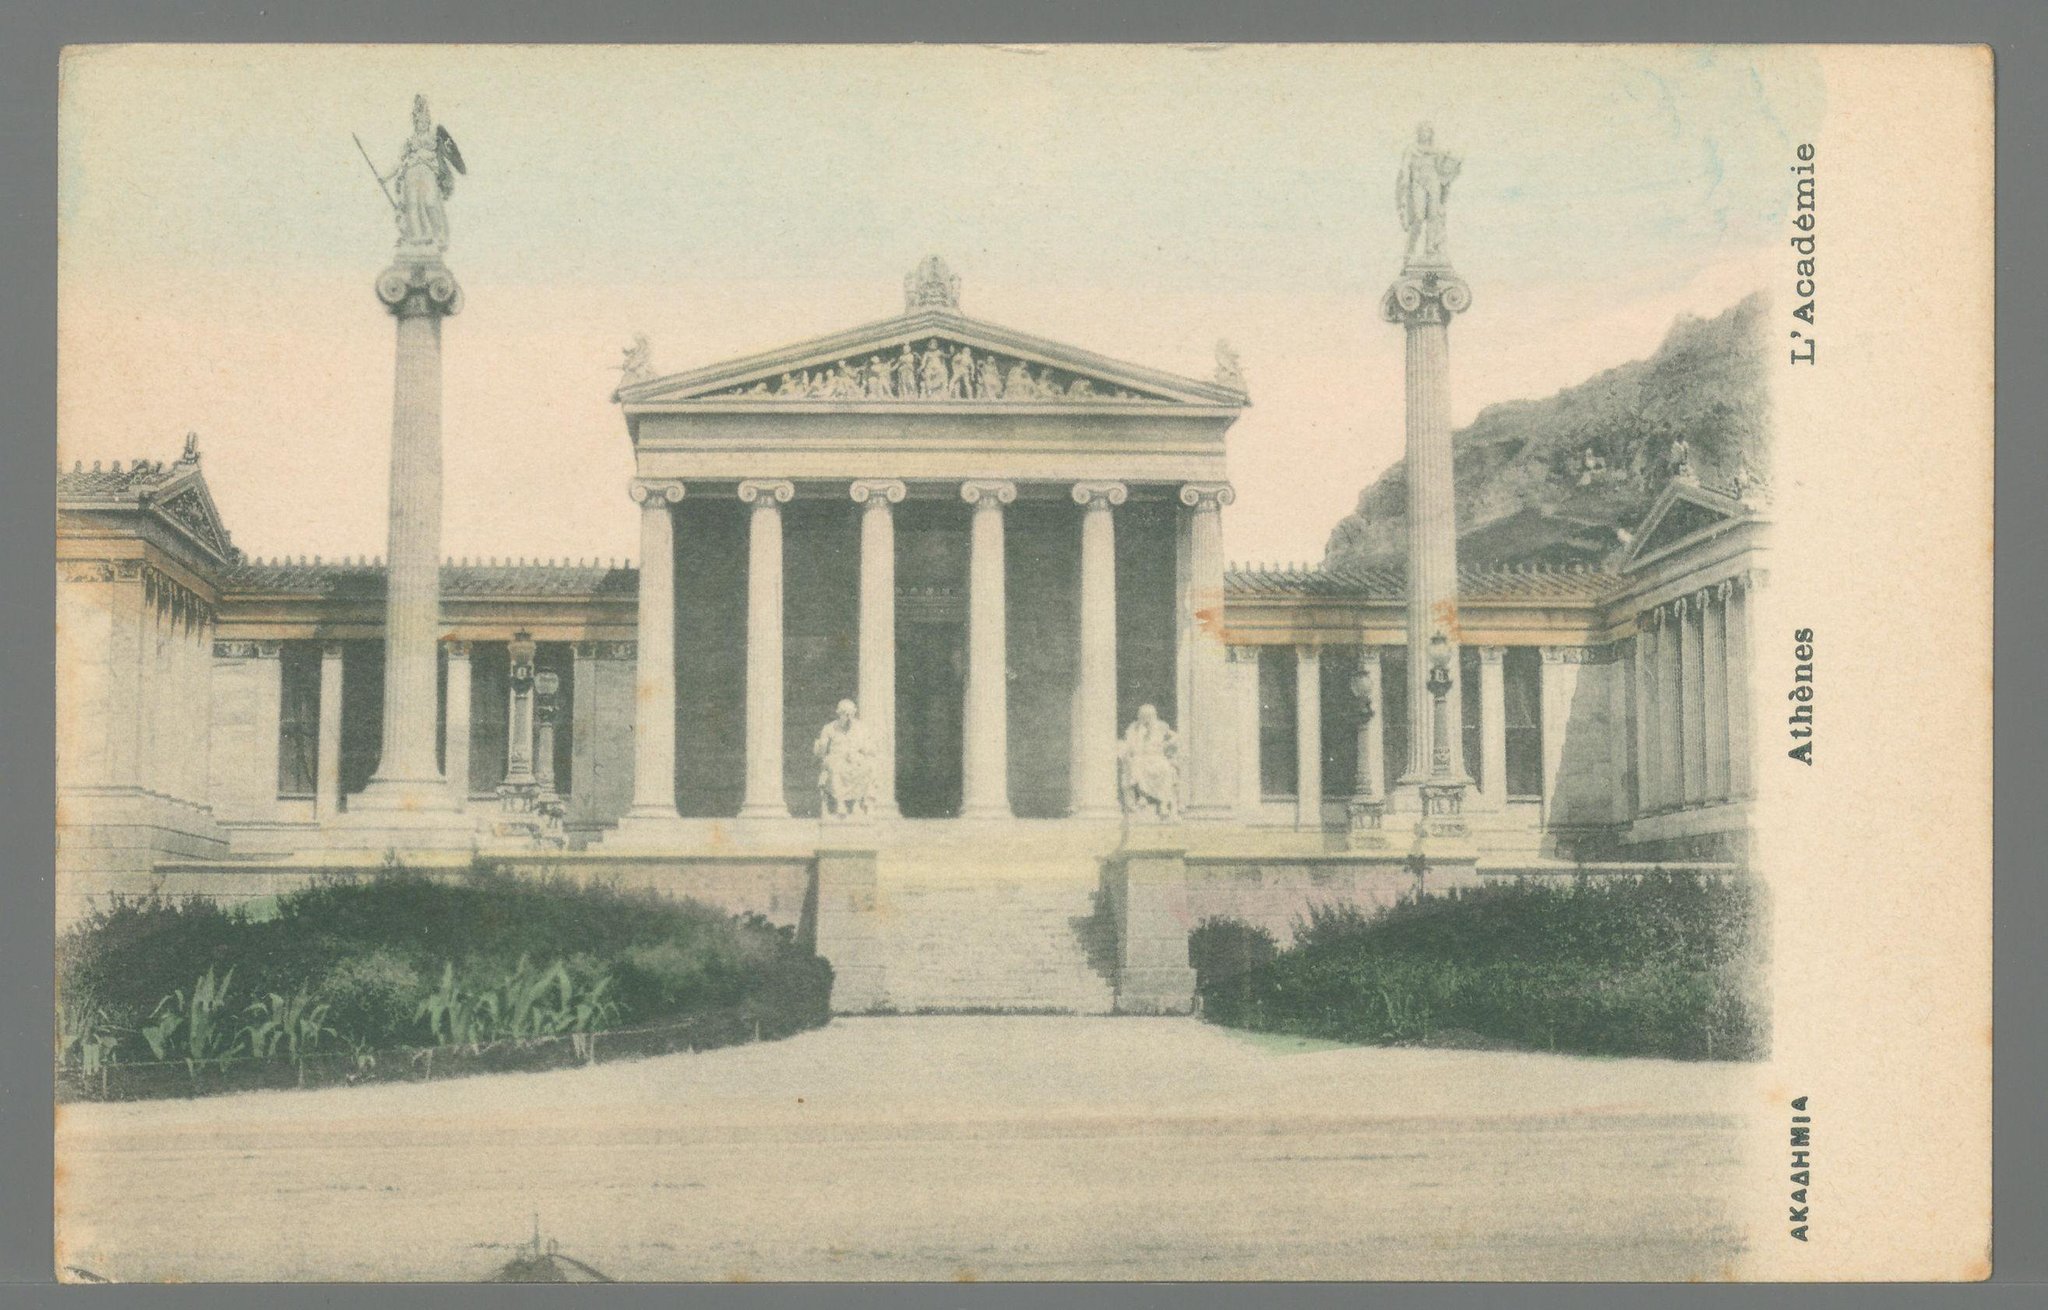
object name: photomechanical print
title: Athènes. L'Académie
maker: Anonymous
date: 1906-1930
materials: cardboard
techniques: photograph, hand coloring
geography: athens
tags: column, pillar ~ architecture, university building, college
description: Voor de Franse titel staat de titel in het Grieks.